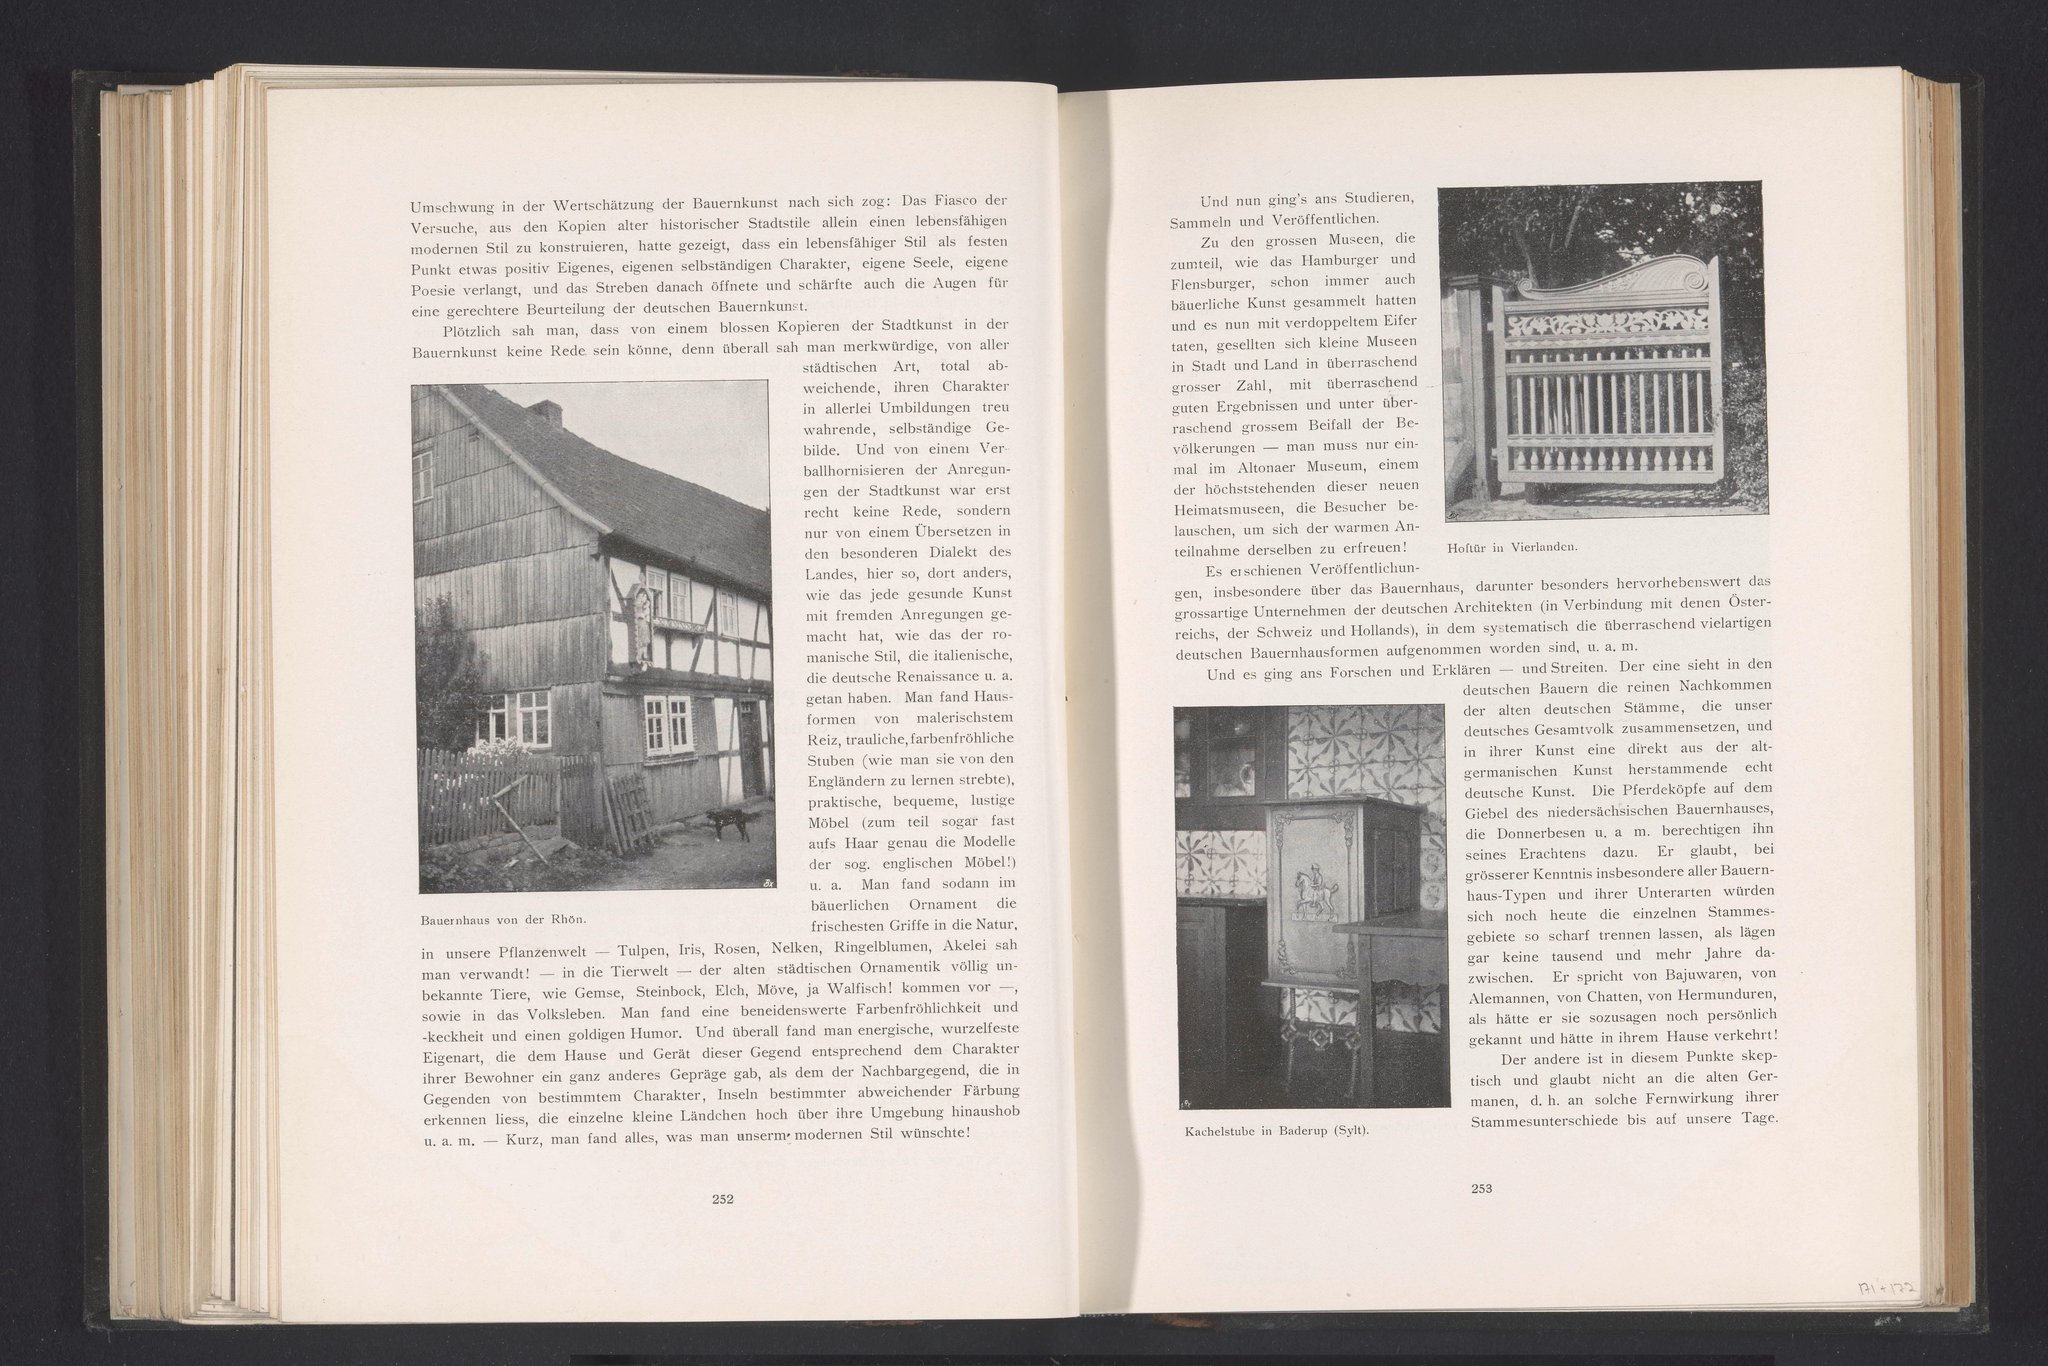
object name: photomechanical print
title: Kachelstube in Baderup (Sylt)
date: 1898-1903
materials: paper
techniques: autotype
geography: sylt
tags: interior of the house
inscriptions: monogram: ‘BX’